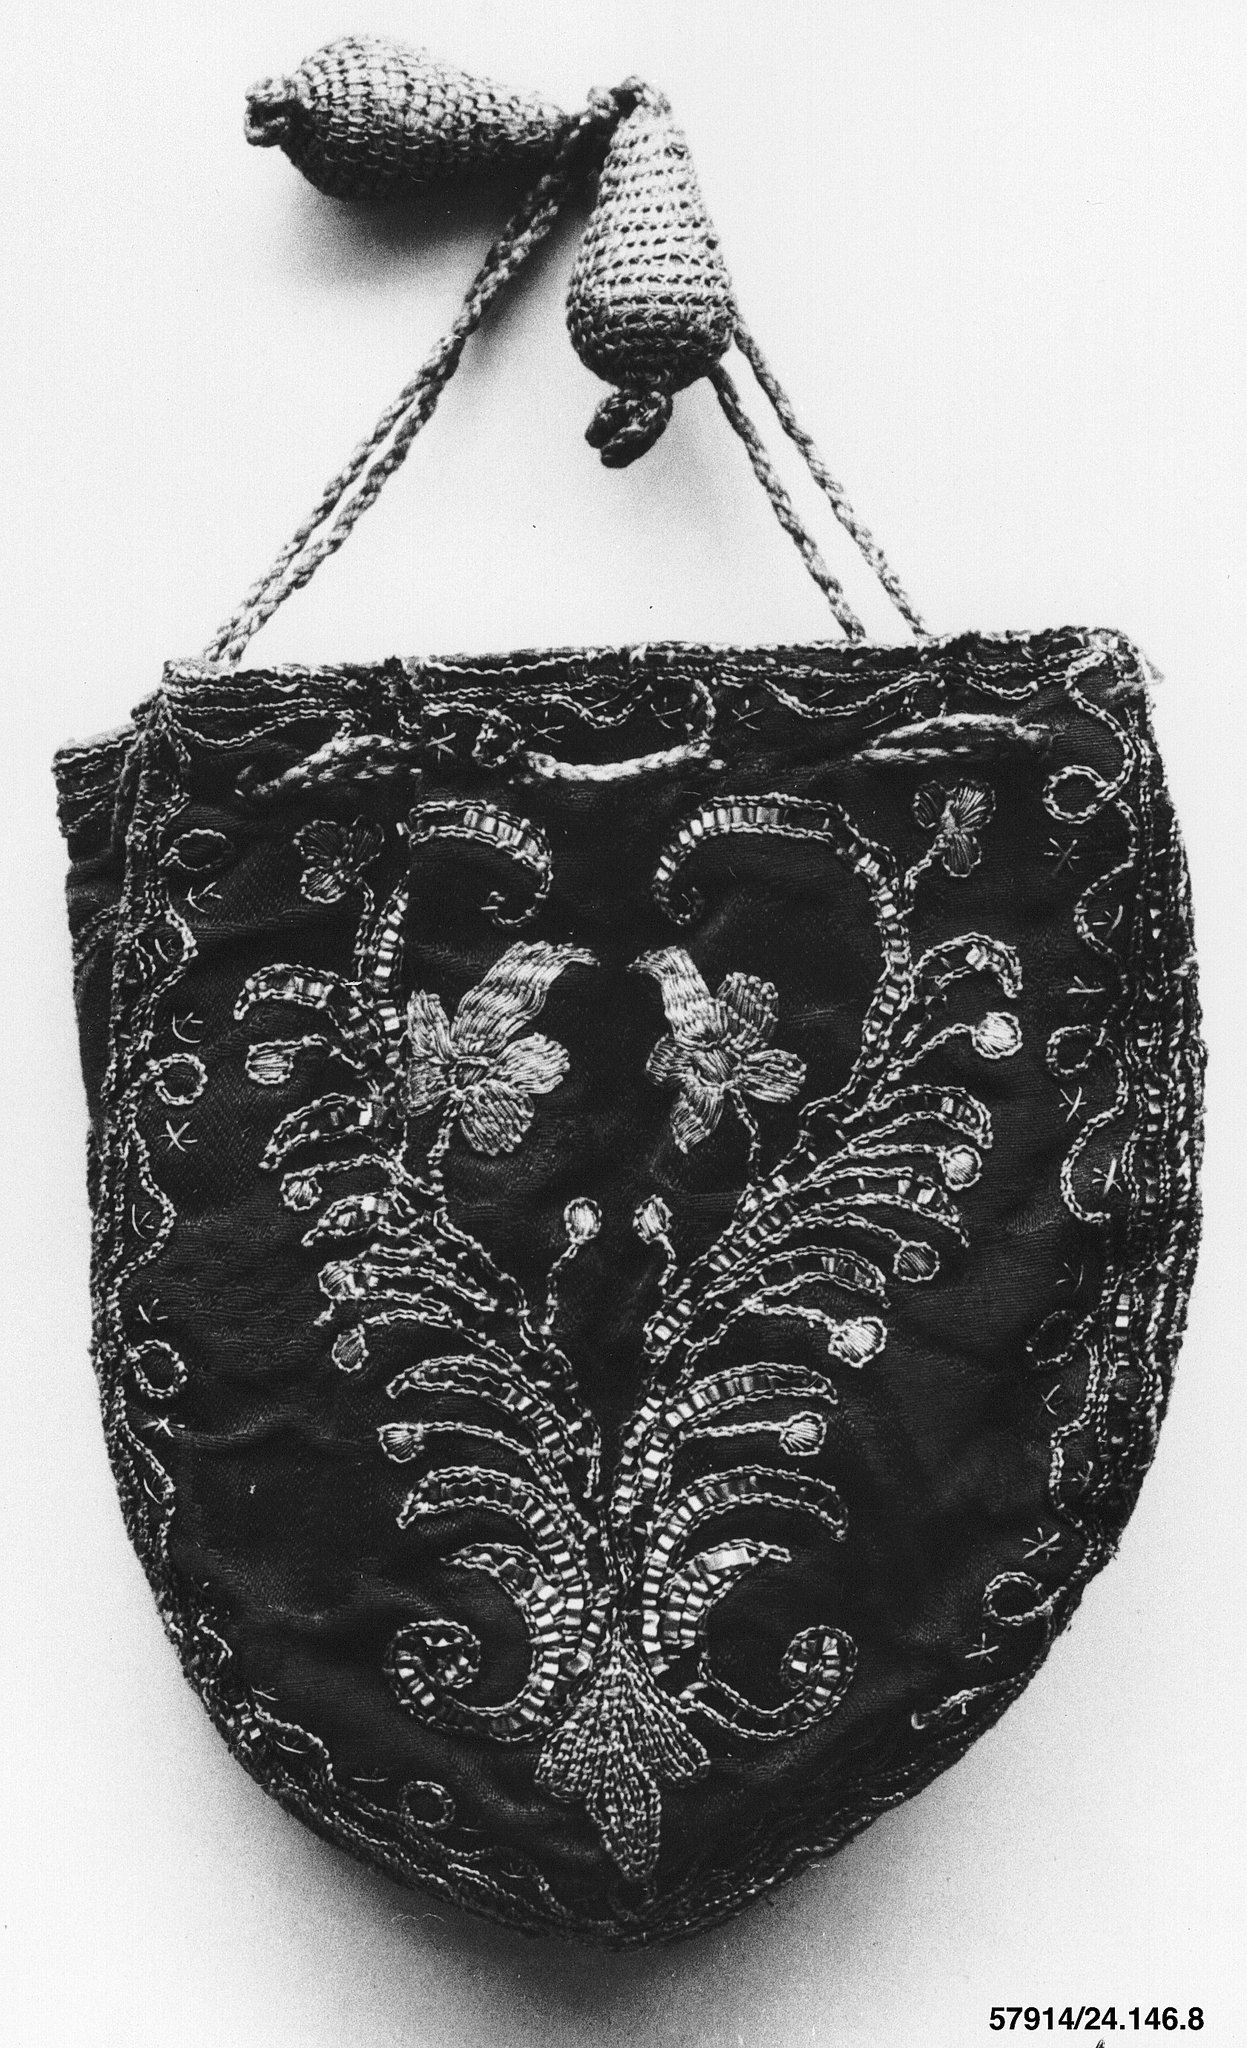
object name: bag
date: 1601-1633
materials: metal thread, silk